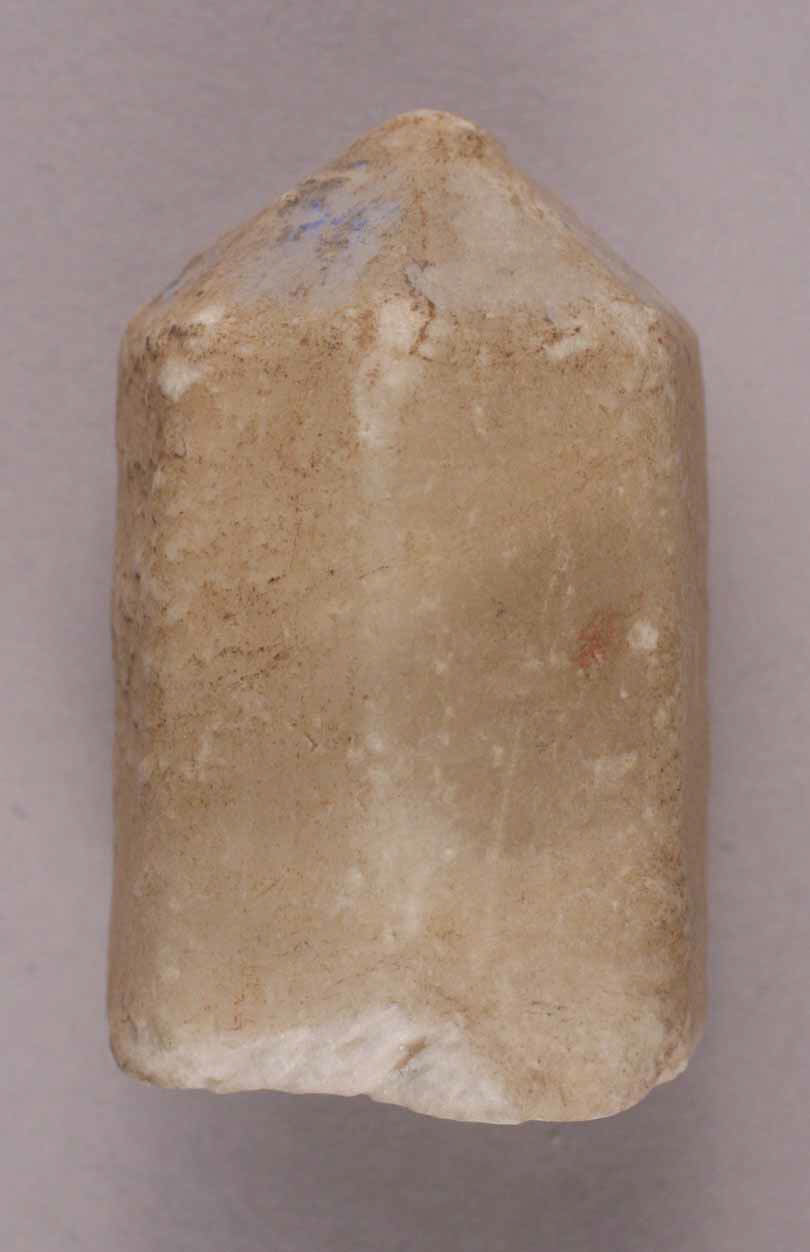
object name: chess piece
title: Chess Piece, Pawn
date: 801-1200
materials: alabaster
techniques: carving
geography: iran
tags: chess,games